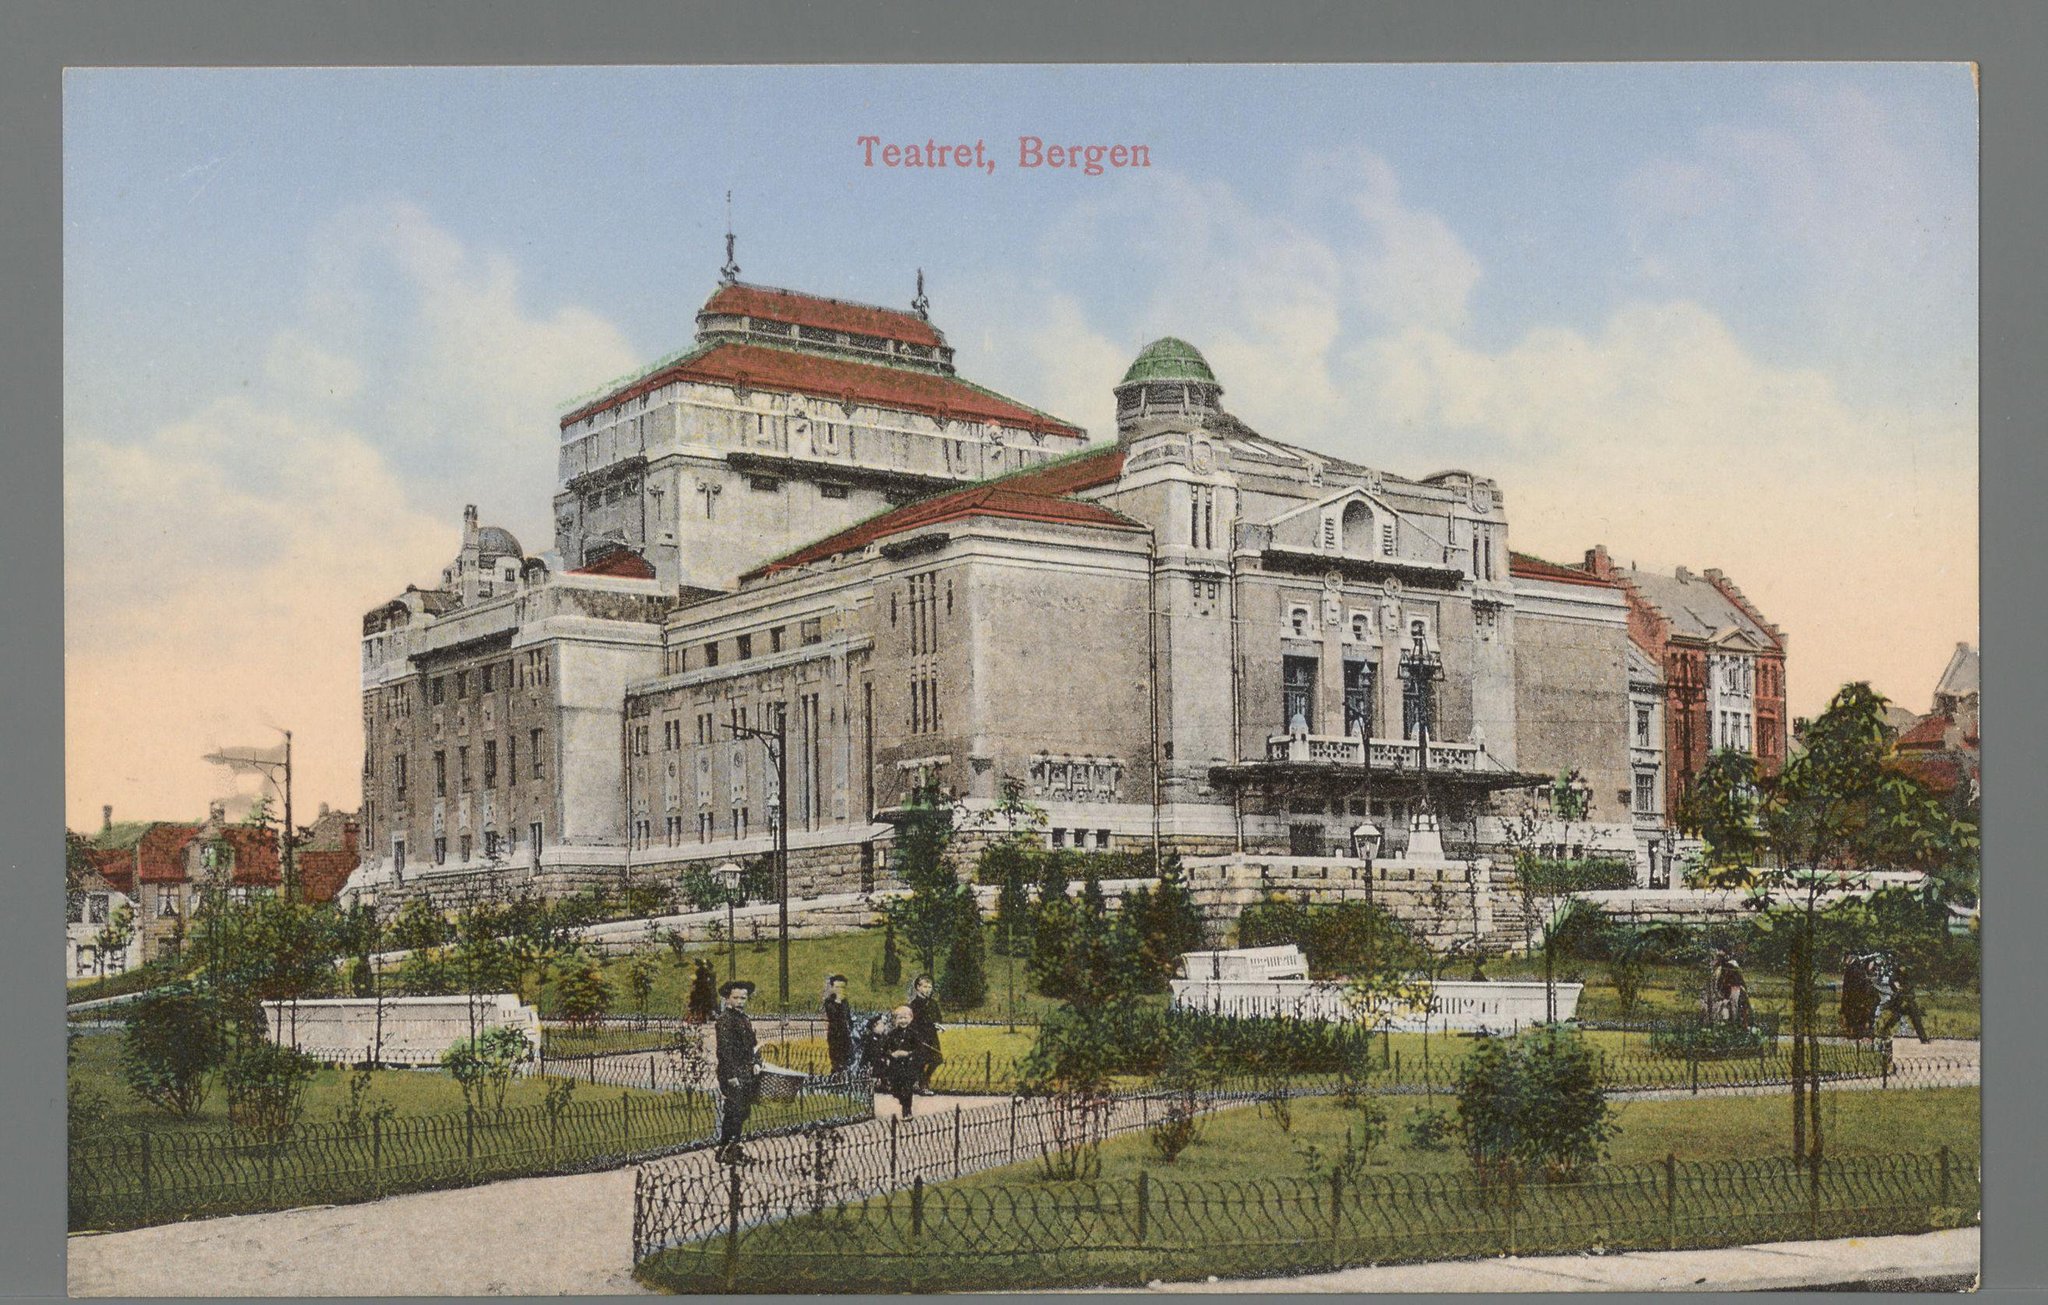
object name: photomechanical print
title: Teatret, Bergen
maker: Anonymous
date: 1904-1930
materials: cardboard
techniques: photograph, lithograph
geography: bergen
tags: park, theatre (building)